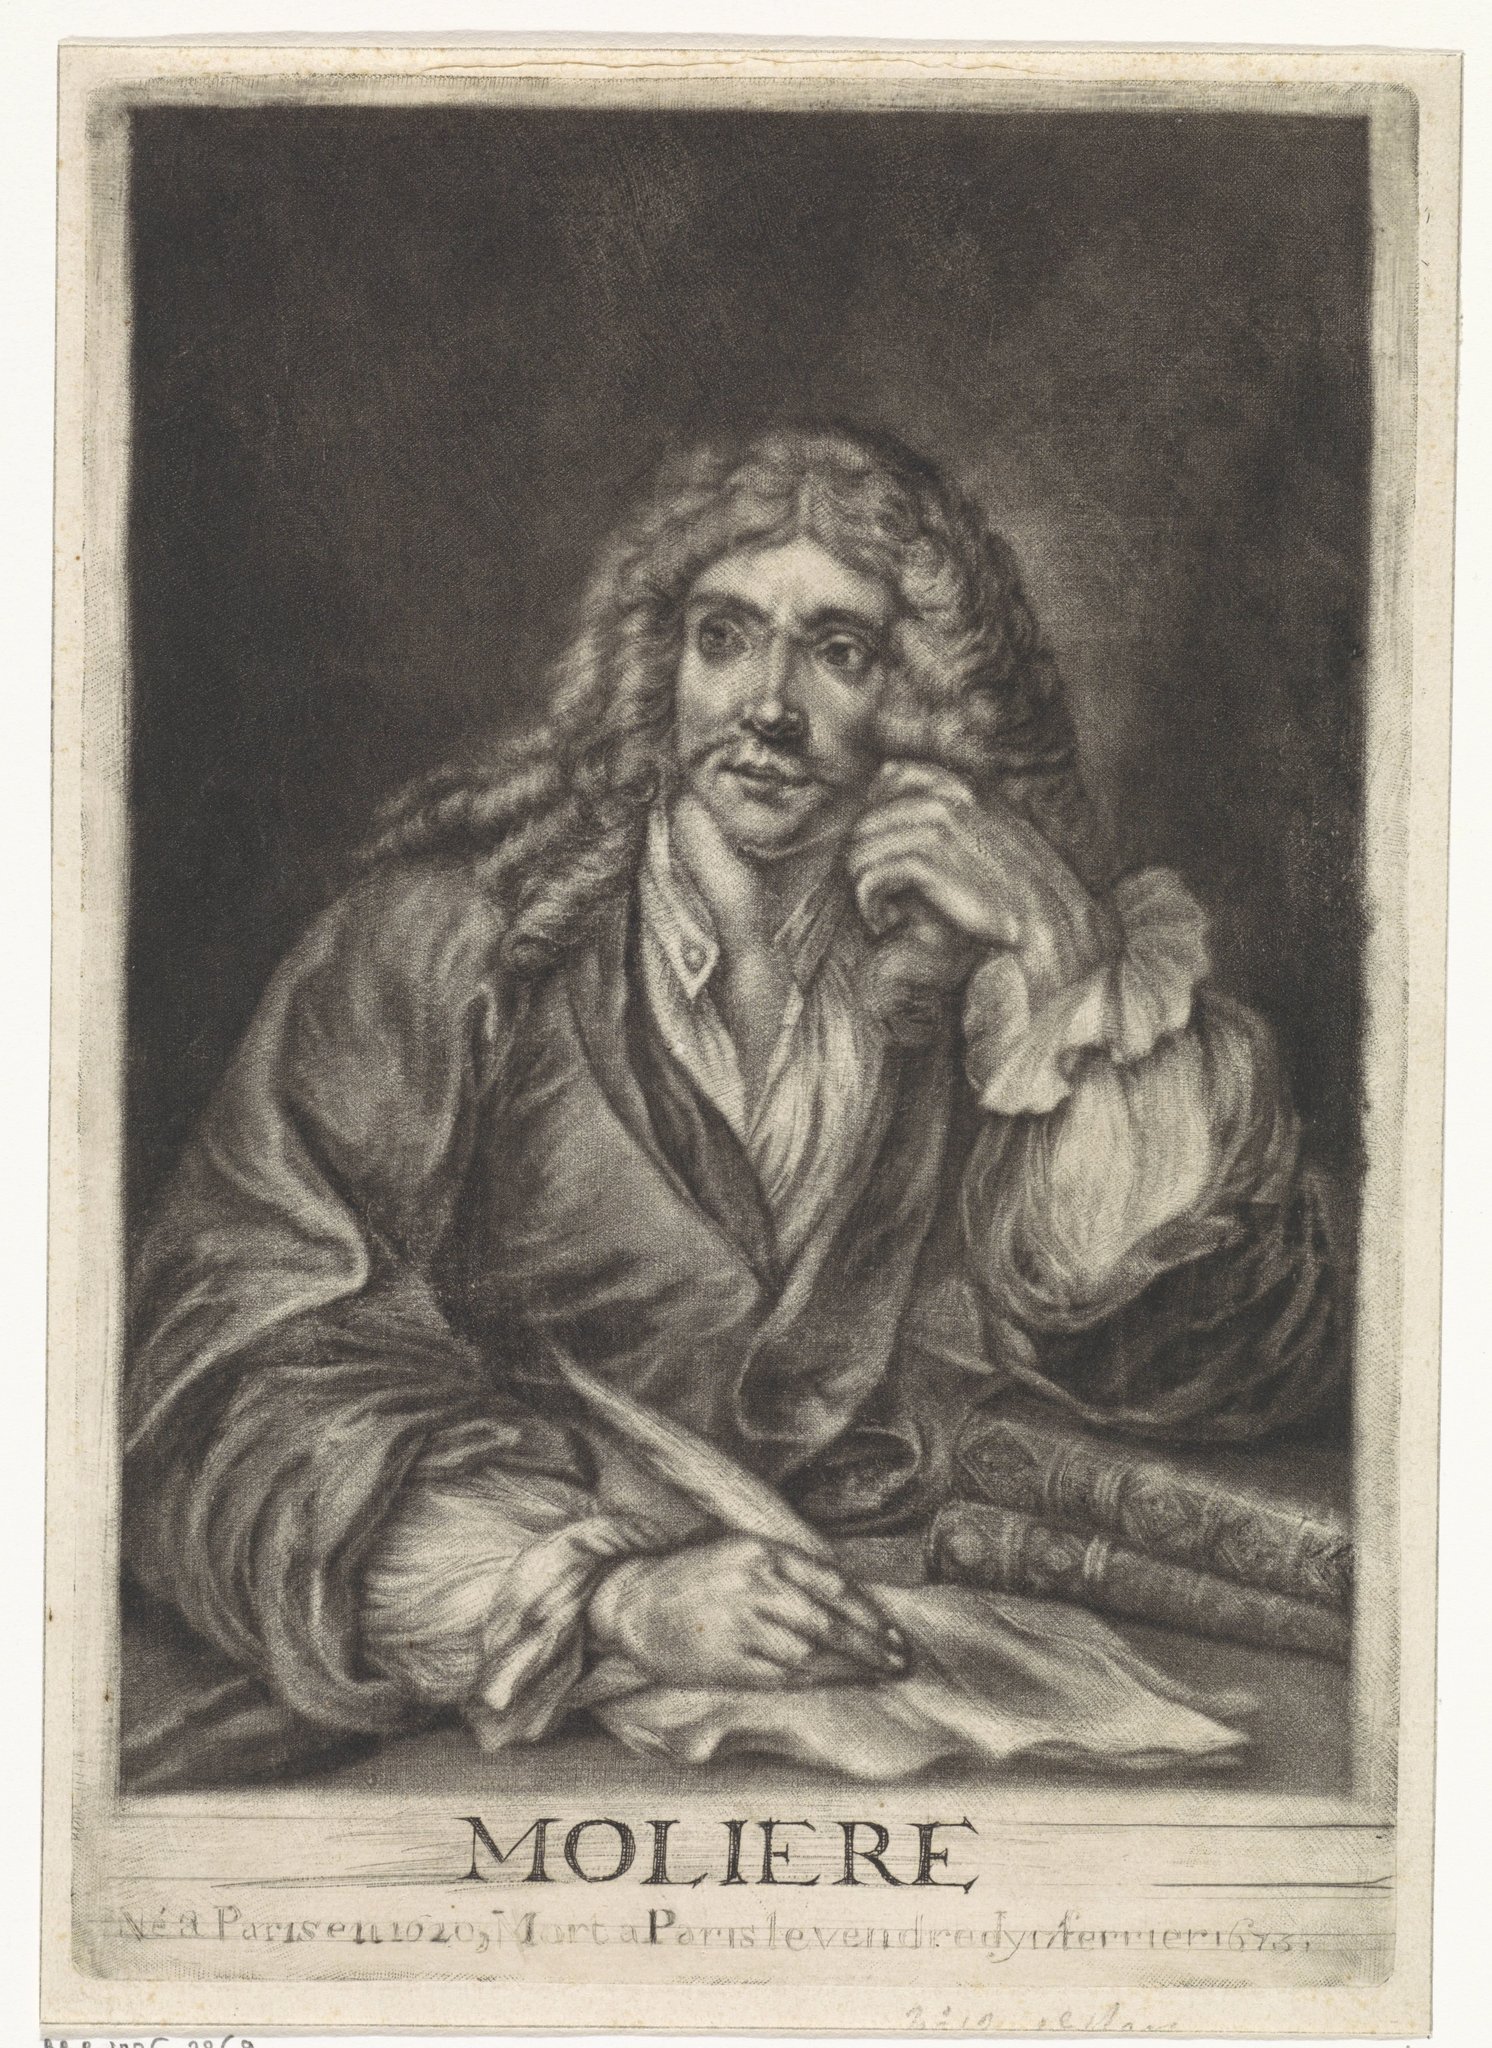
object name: print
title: Portret van Jean Baptiste Poquelin de Molière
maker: johannes de groot (ii)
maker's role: painter, print maker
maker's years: 1688-1796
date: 1699-1776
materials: paper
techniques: engraving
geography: northern netherlands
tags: paris, jean baptiste poquelin molière, handwriting, writing as activity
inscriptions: collector's mark: Lugt 2228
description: De toneelschrijver en acteur Jean Baptiste Poquelin Molière schrijvend aan een bureau. Onder zijn arm een stapeltje boeken. In de marge zijn geboorte- en sterfdata.